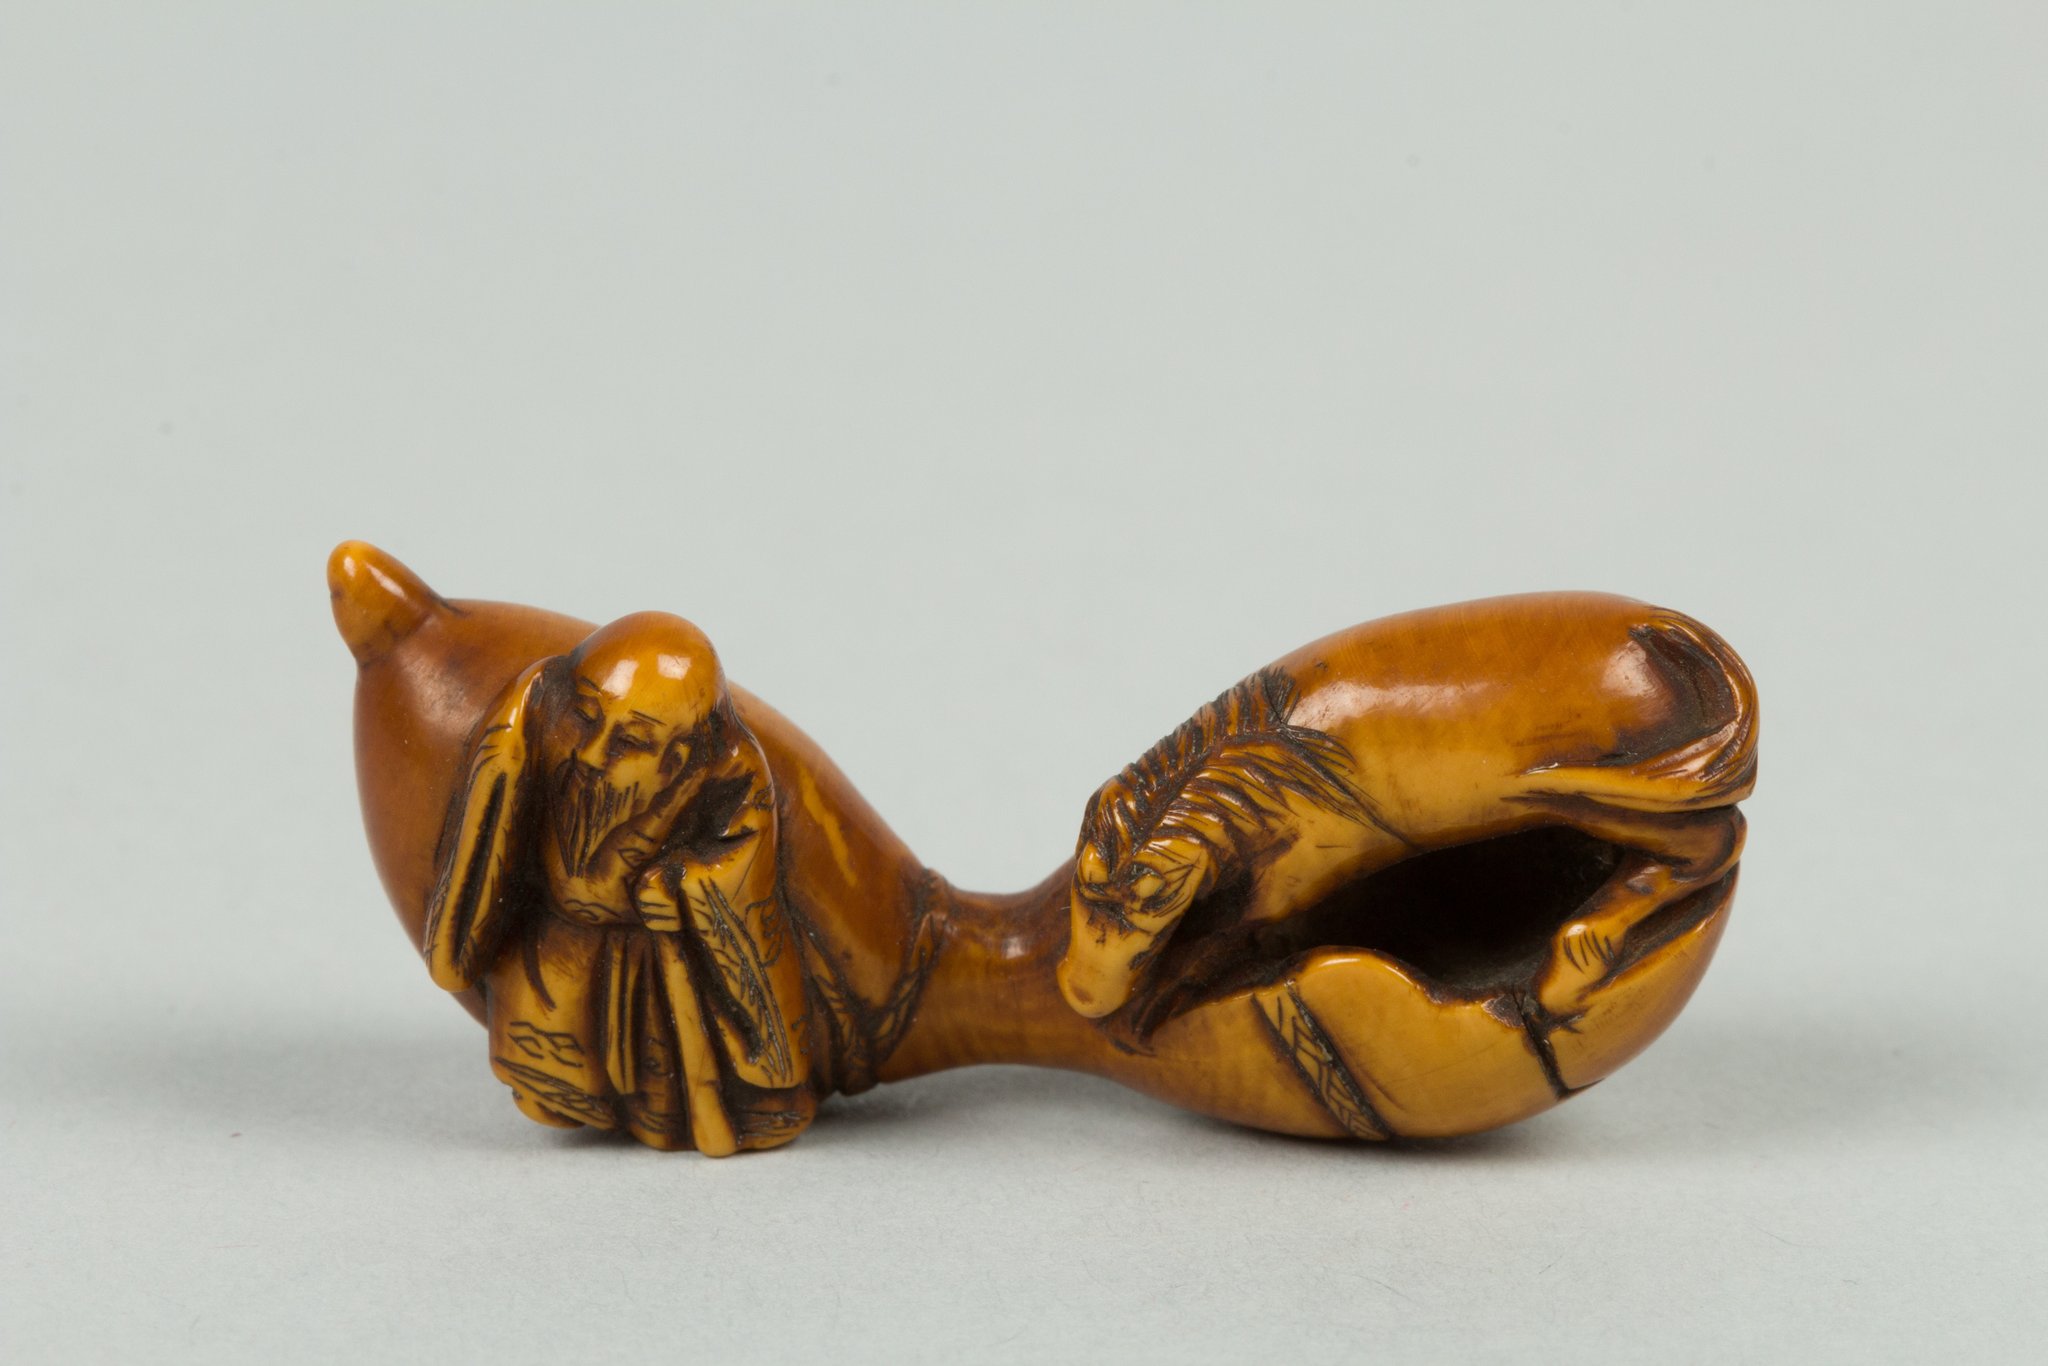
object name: netsuke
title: Netsuke of Small Gourd with Horse and Man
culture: japanese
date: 1801-1900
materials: ivory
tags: men,horses,gourds